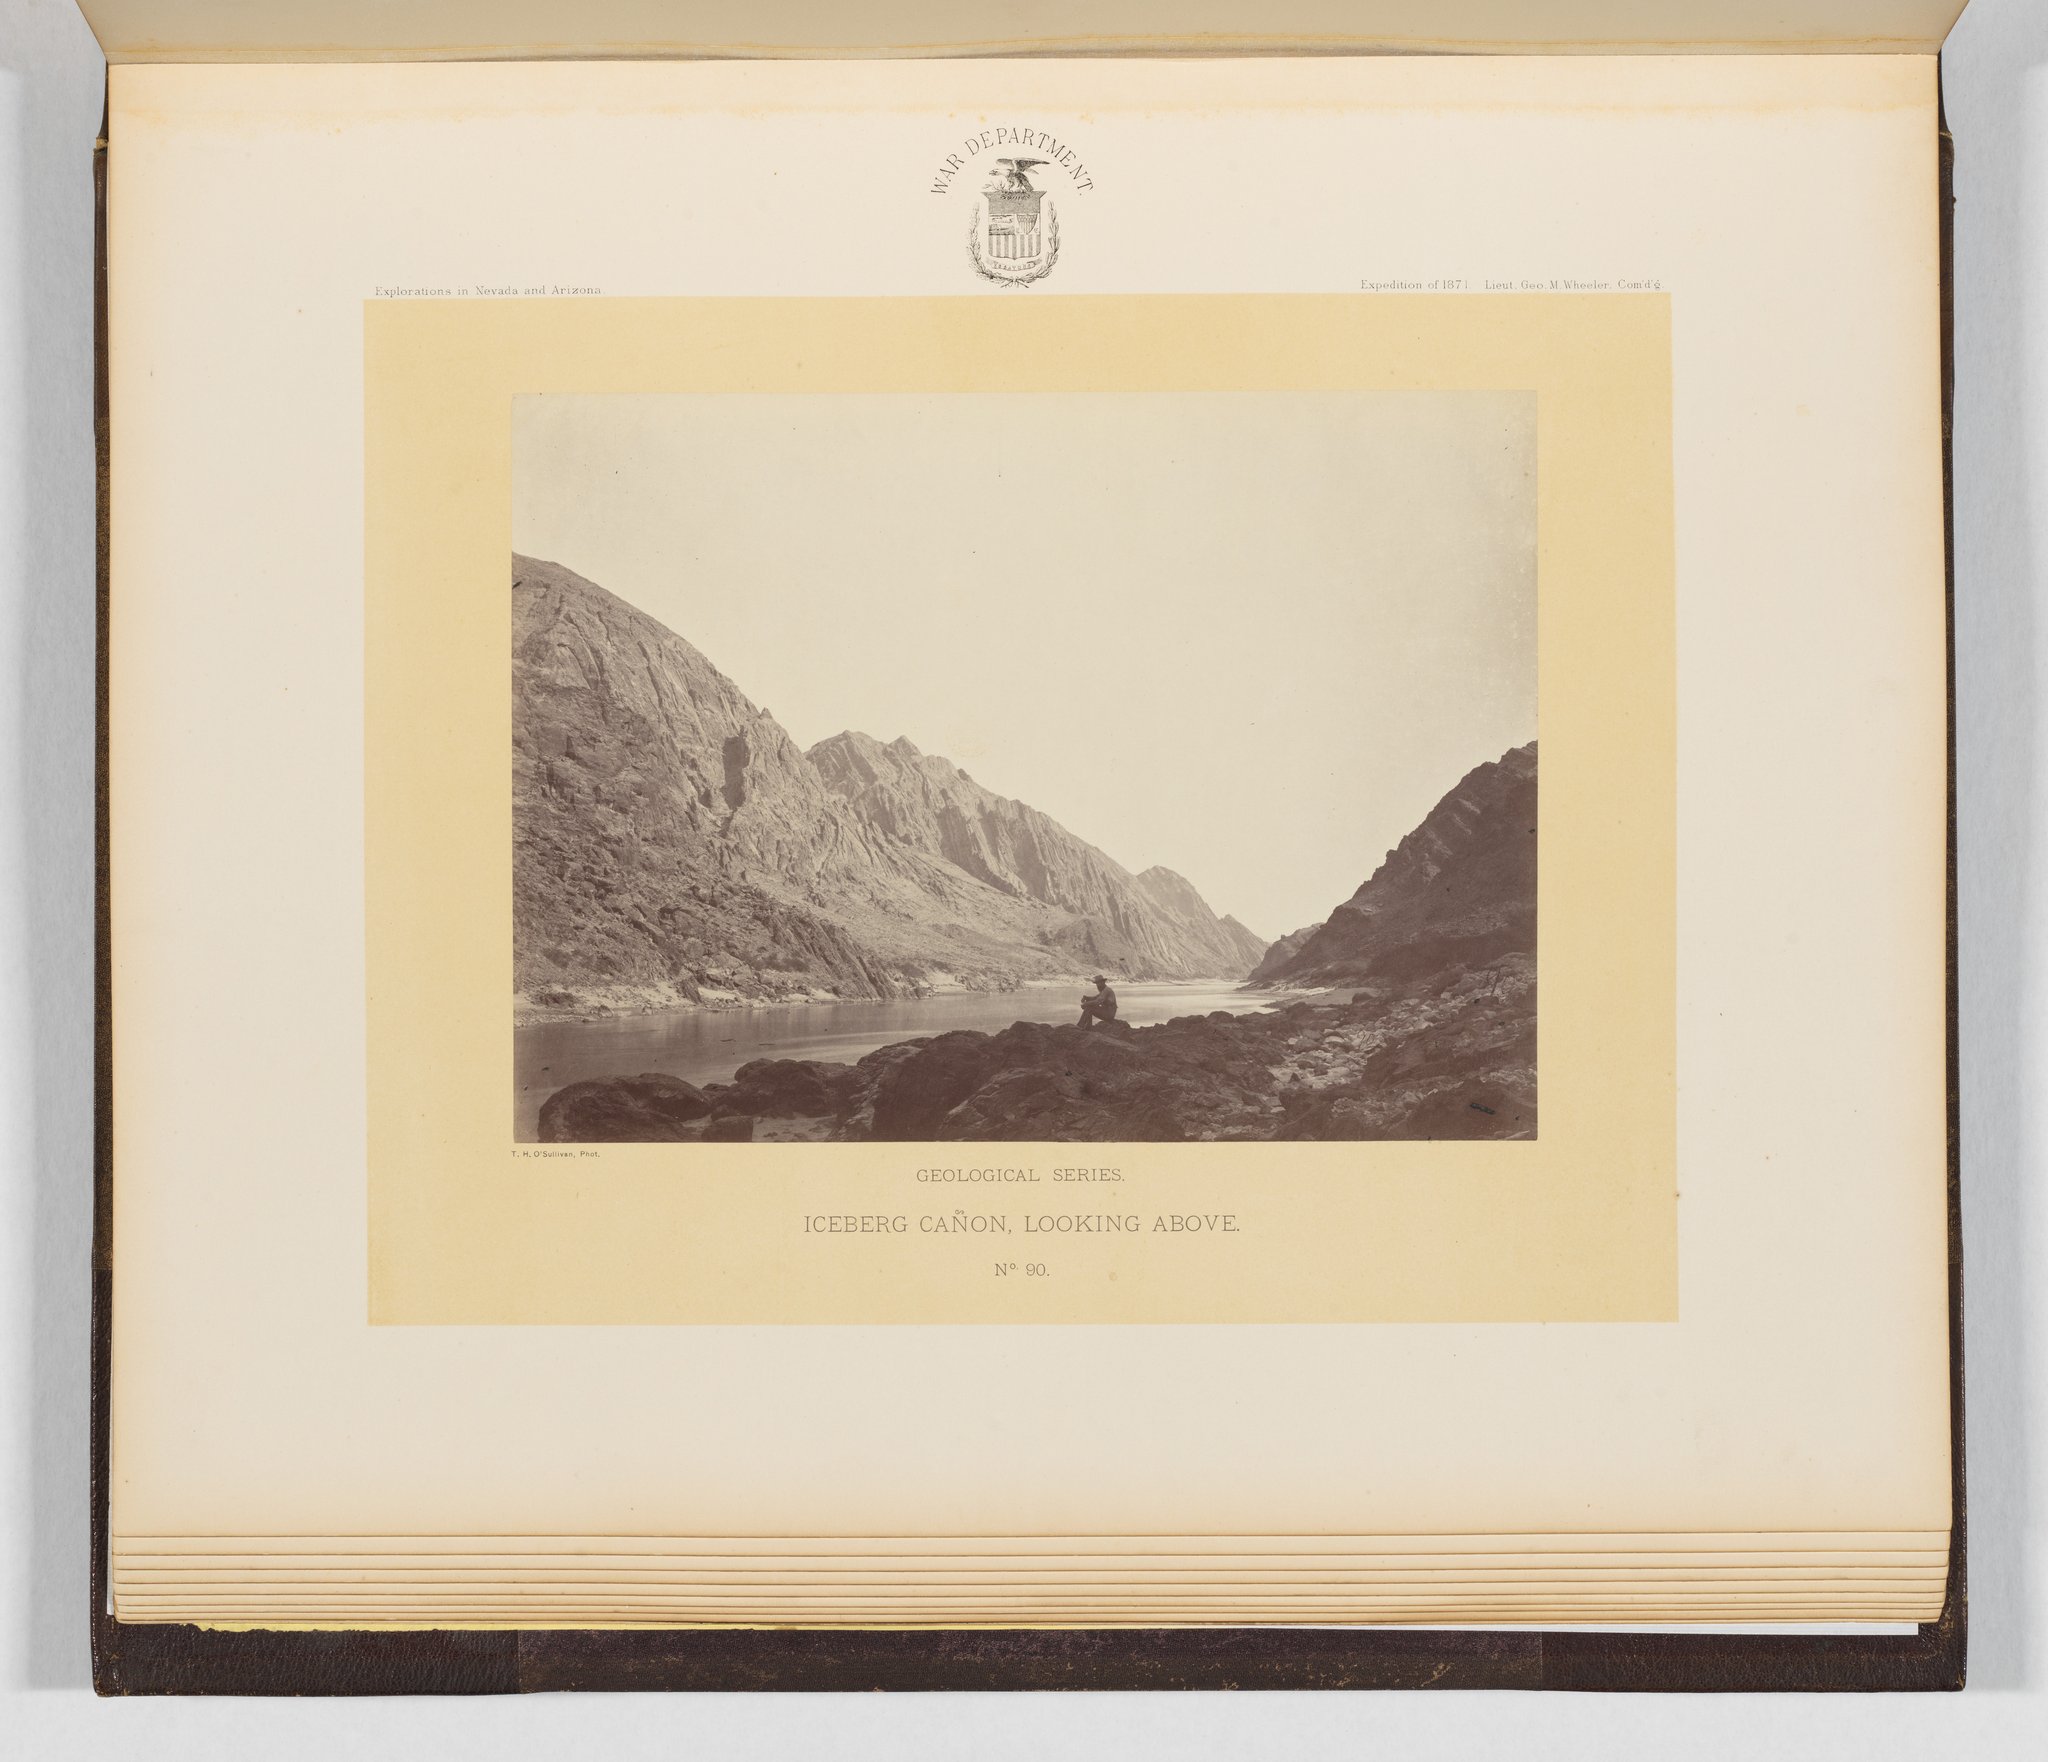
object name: photograph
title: Iceberg Cañon, Looking Above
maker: timothy h. o'sullivan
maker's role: artist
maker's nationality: american, born ireland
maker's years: 1840-1882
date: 1871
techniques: albumen silver print, glass negative